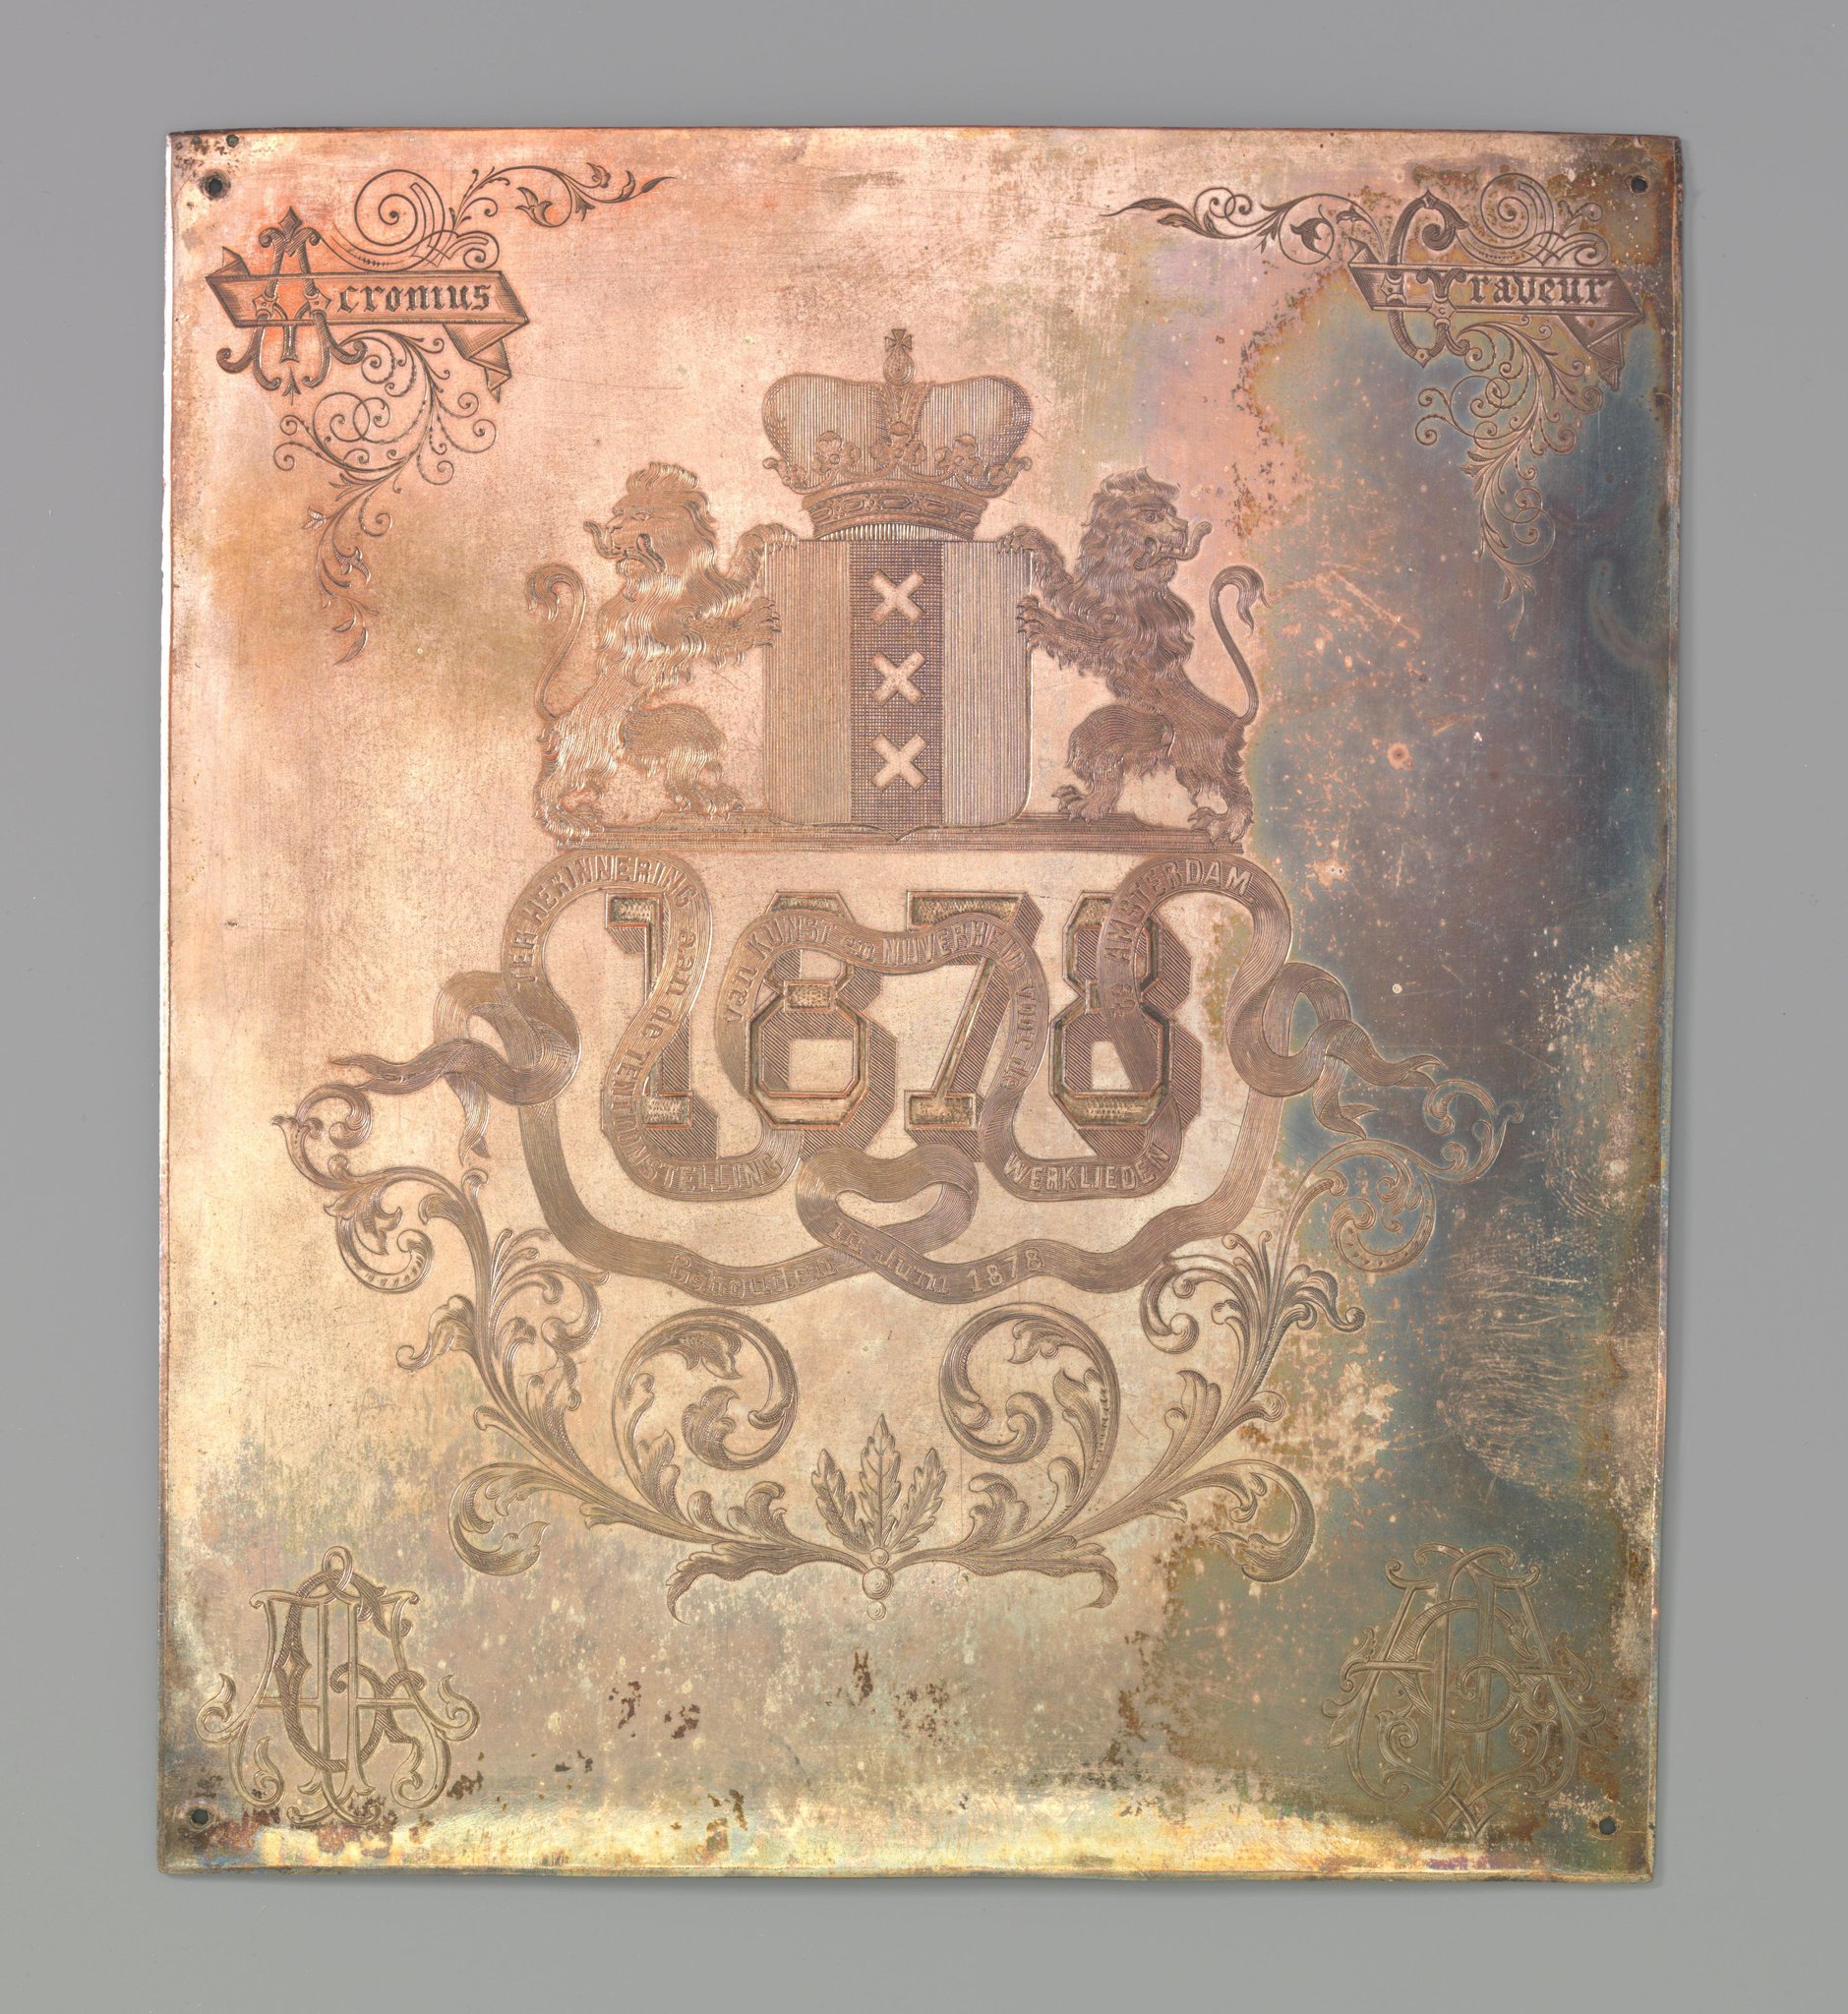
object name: copper plate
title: Herinneringsplaat voor de Tentoonstelling van Kunst en Nijverheid voor de Werklieden te Amsterdam, juni 1878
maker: g. acronius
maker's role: print maker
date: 1878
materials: copper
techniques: engraving